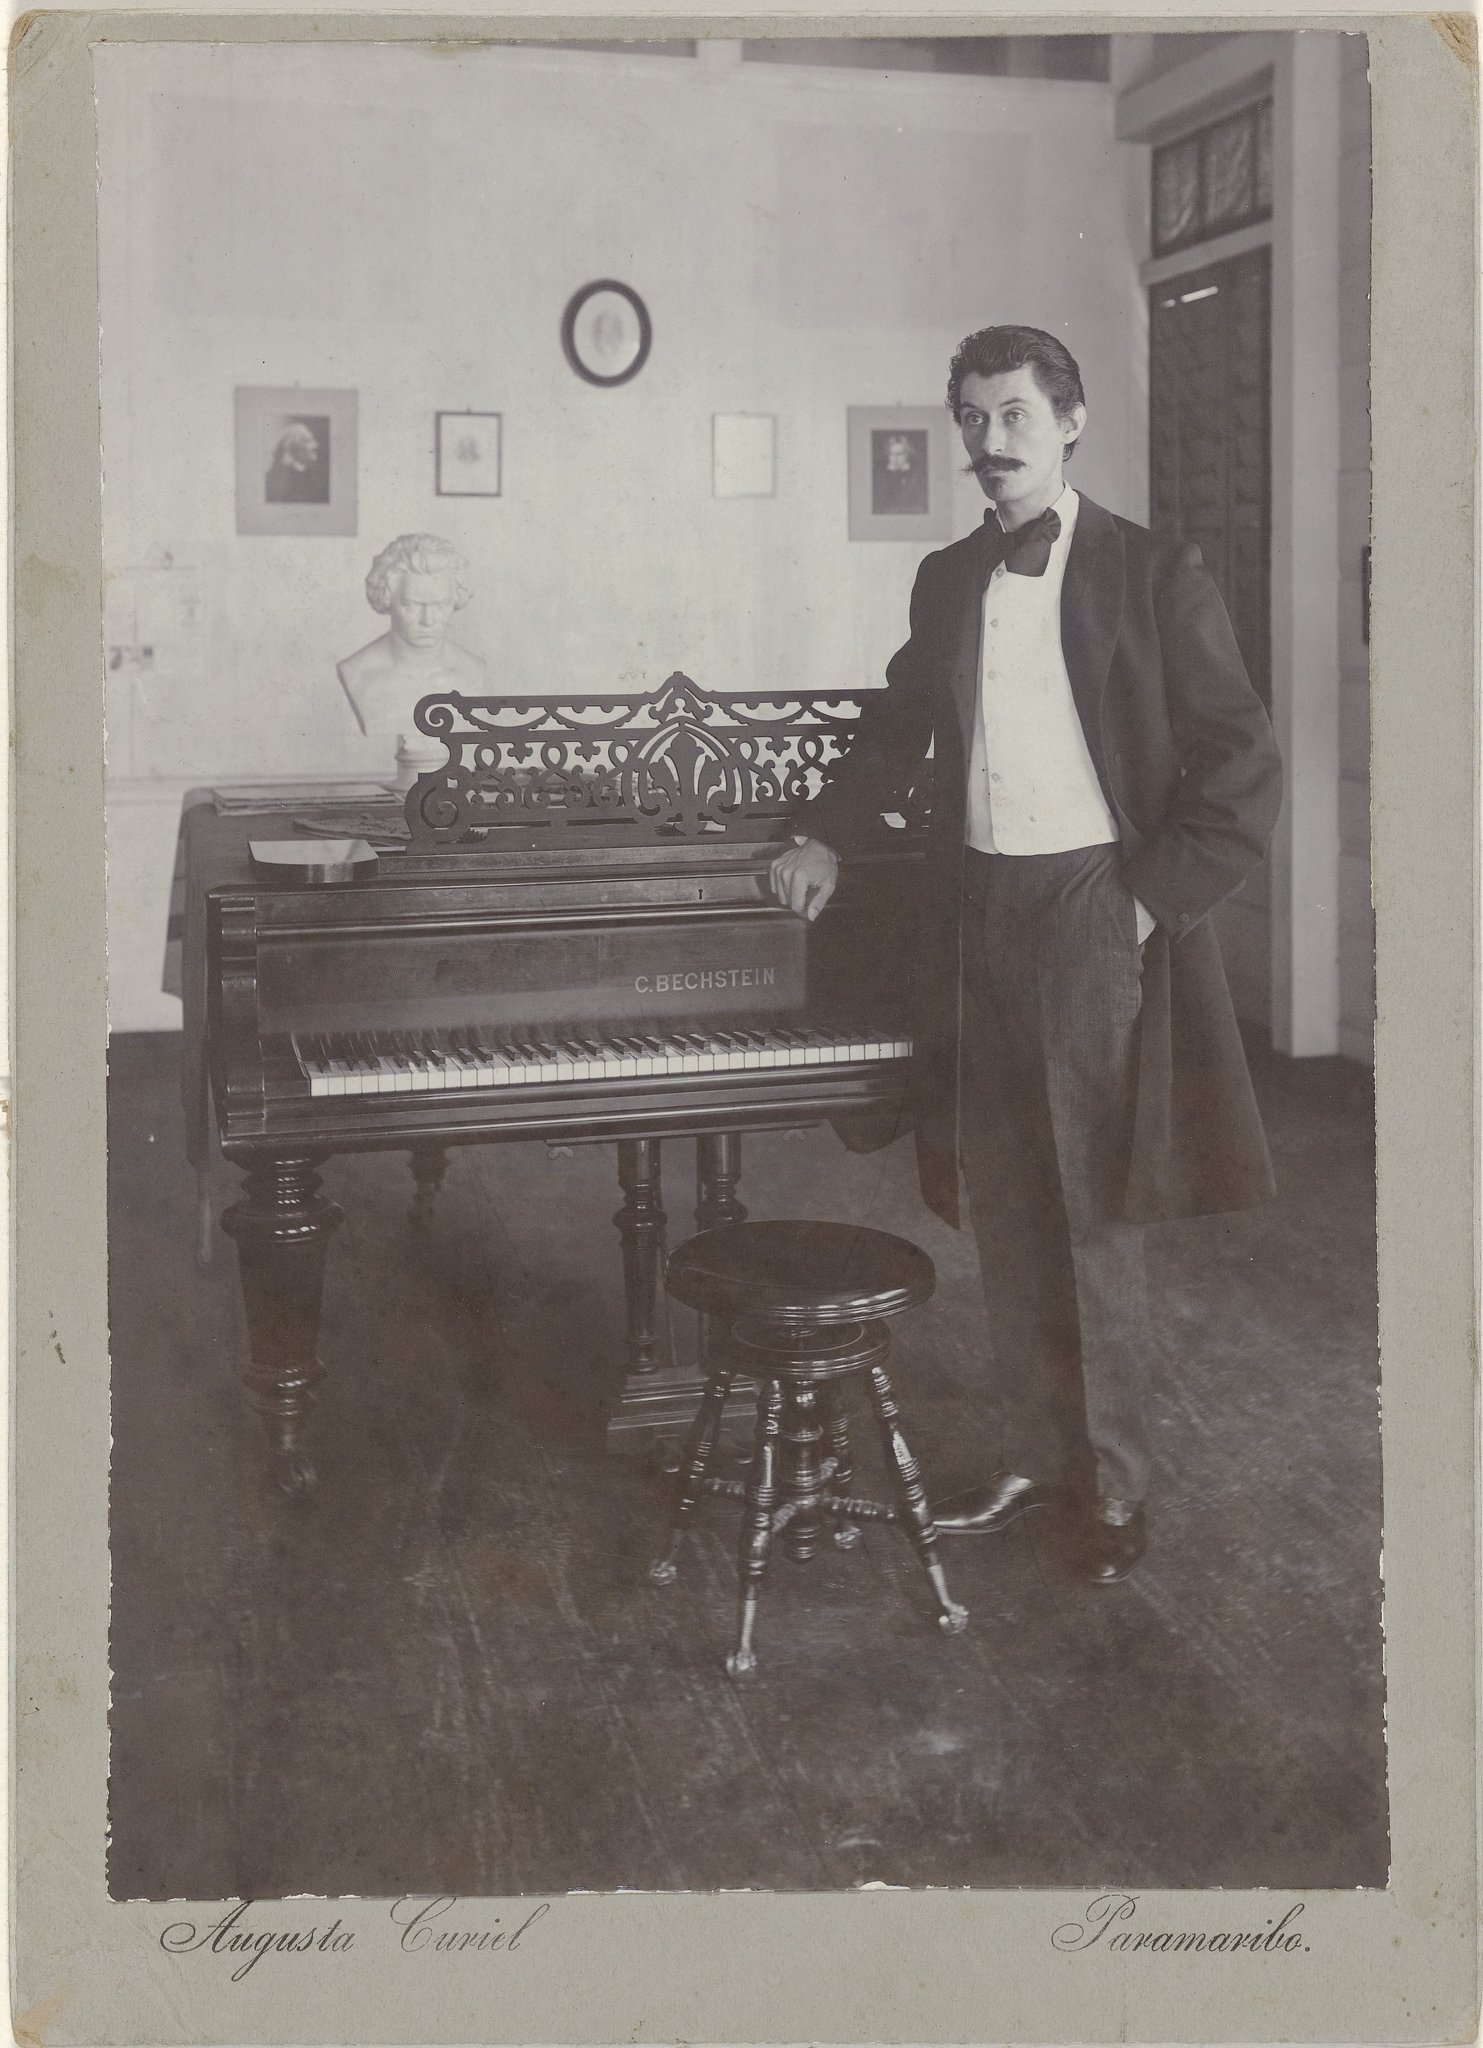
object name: photograph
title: Portret van Aleidus Coenen, componist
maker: augusta curiel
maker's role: fotograaf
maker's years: 1873-1937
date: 1907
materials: cardboard, photographic support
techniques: photography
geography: paramaribo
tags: grand piano, portrait of composer, suriname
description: Geposeerd portret van een man met snor, leunend tegen een Bechstein vleugel.